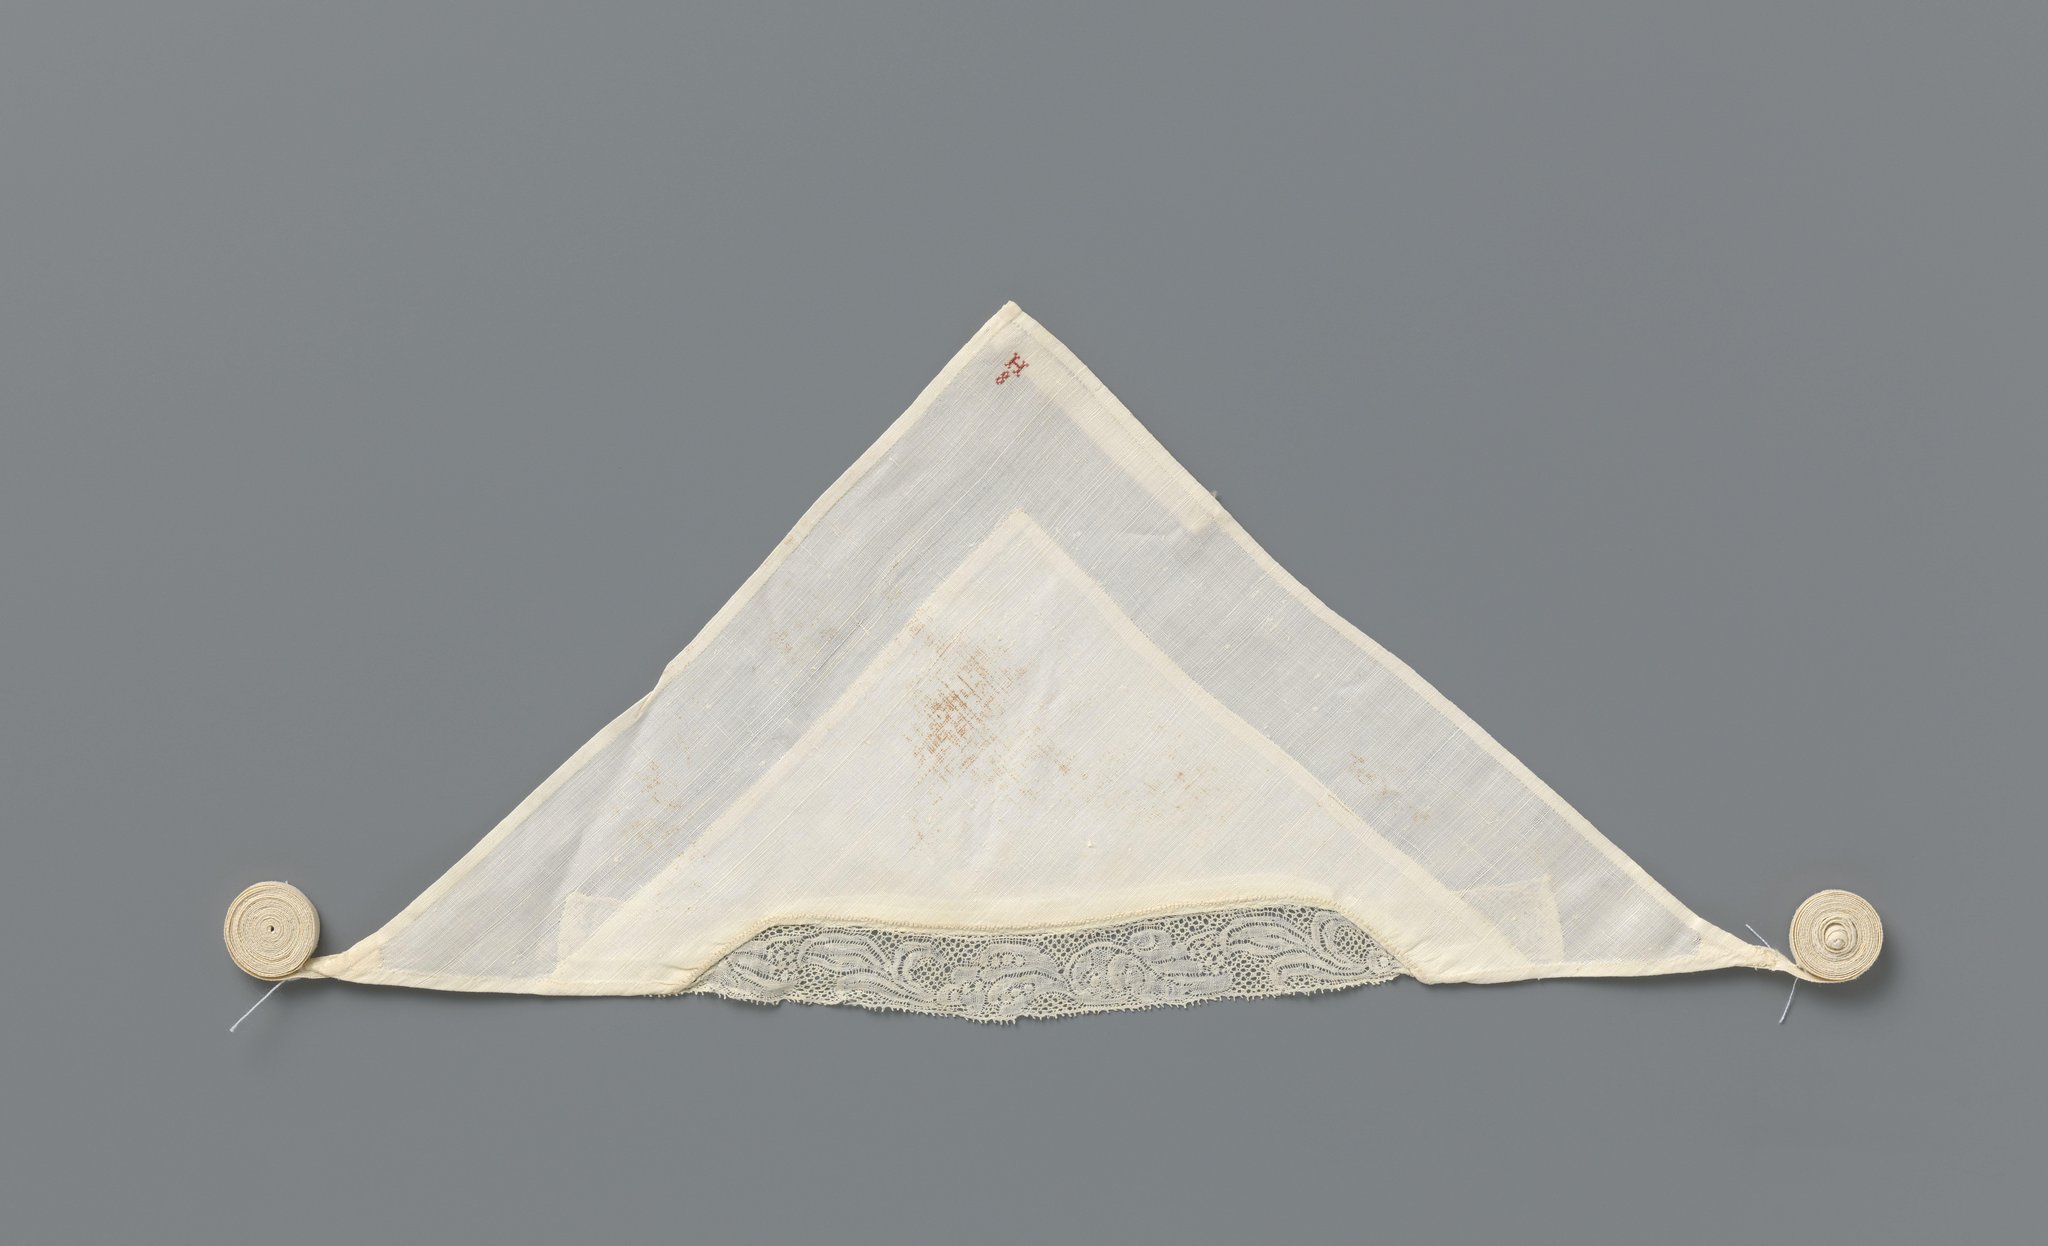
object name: fontaneldoek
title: Fontaneldoek van wit linnen met kant; in rode kruissteek gemerkt: H8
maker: Anonymous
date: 1750-1900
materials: linen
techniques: cross stitching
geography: europe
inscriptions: inscription: ‘H / K’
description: 12 linnen fontanelletjes met verschillende kant afgezet , 4 gemerkt LH8, 3 gem. H8, 5 gem. HVS(Gr. Hoogenhuize "1772-1852" tr. 1802 S.E. von schmid "1771-1843"). 1 van damast gem. HH6 (W.r. Hoogenhuize "1747-1804" tr 1787 W. Helmerich "1752").